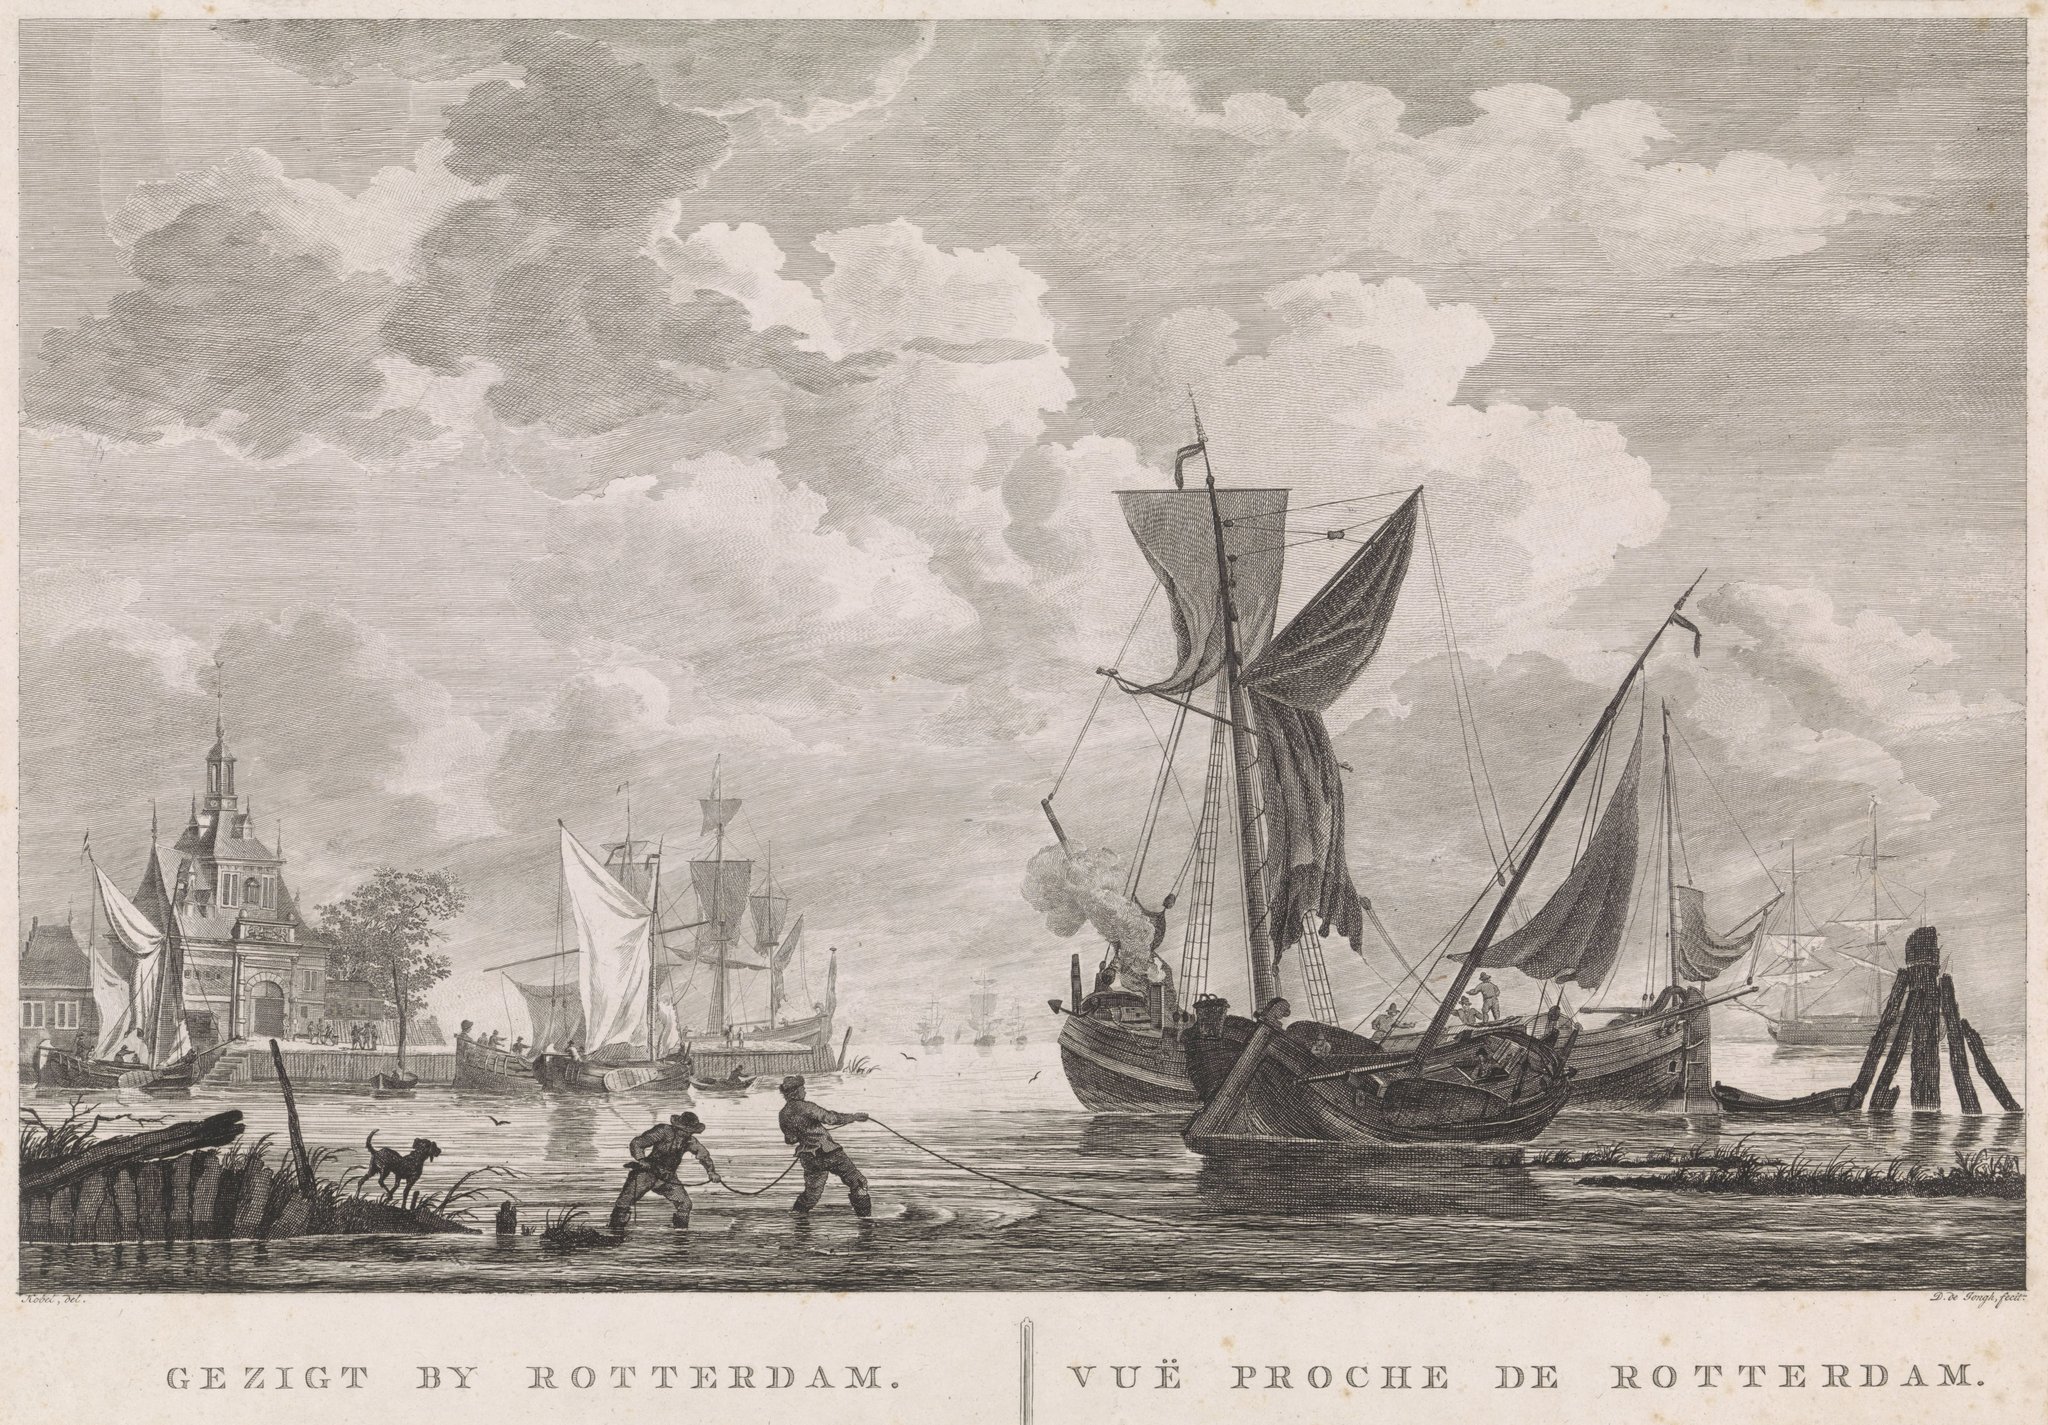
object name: print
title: Gezigt by Rotterdam / Vuë proche de Rotterdam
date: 1805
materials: paper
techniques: drypoint, engraving, etching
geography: northern netherlands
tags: harbour, rotterdam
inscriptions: collector's mark: Lugt 2228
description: Gezicht op haven te Rotterdam met diverse schepen en links de havenpoort. Op de voorgrond twee mannen in het water en op de kade een hond. In de marge een onderschrift in het Nederlands en in het Frans.